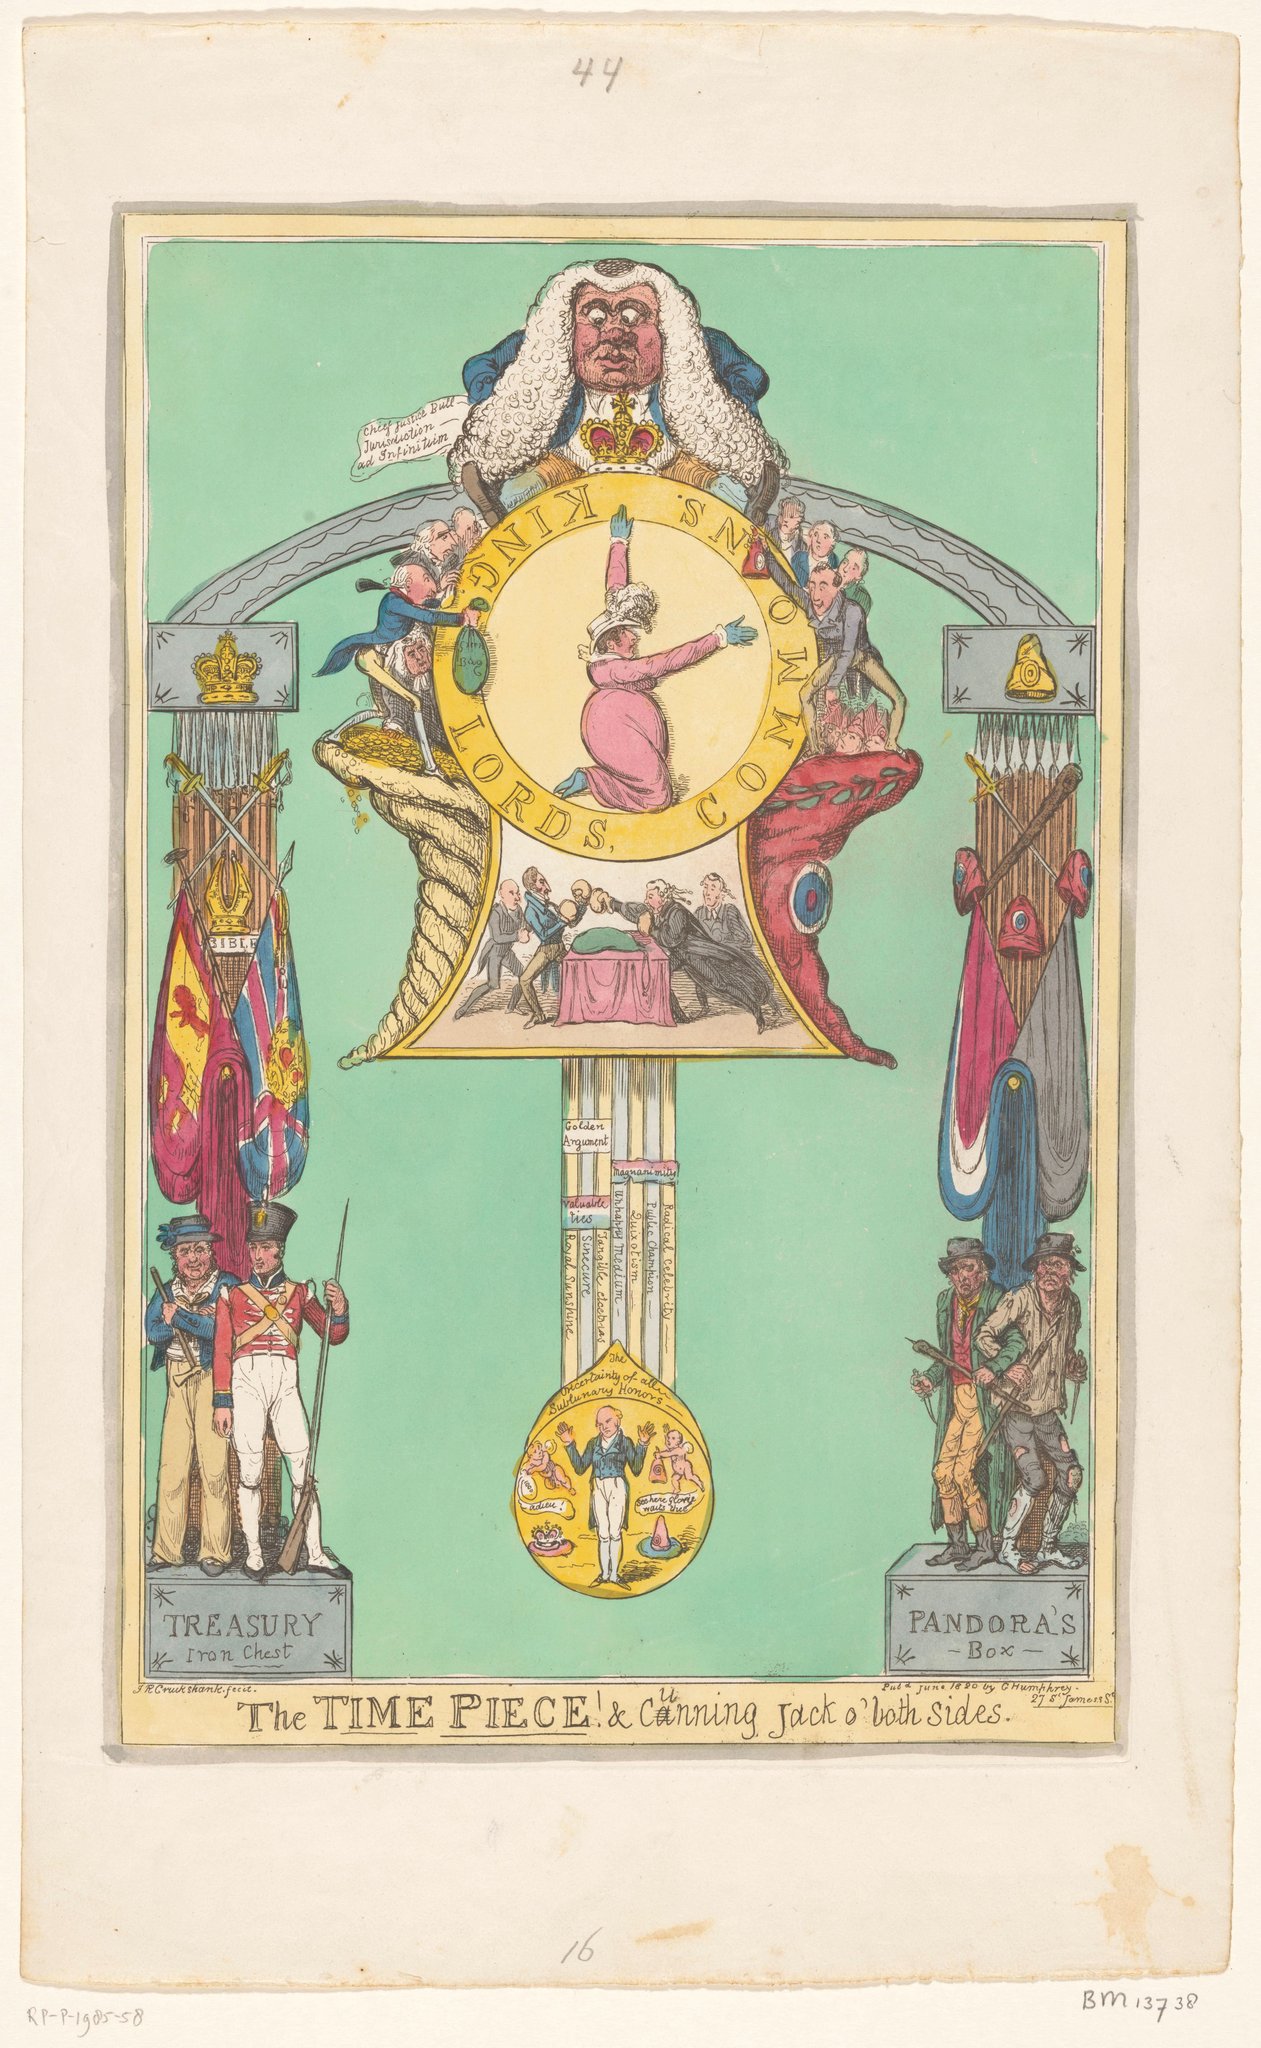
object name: cartoon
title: Klok met de koningin op de wijzerplaat, 1820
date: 1806-1820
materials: paper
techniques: etching, hand coloring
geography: london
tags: clock, political caricatures and satires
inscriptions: collector's mark: Lugt 2228, collector's mark: Lugt 2760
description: Klok waarin de armen van de koningin de wijzers vormen, 1820. Met andere politieke personen, militairen en gewapende Fransgezinde radicalen.